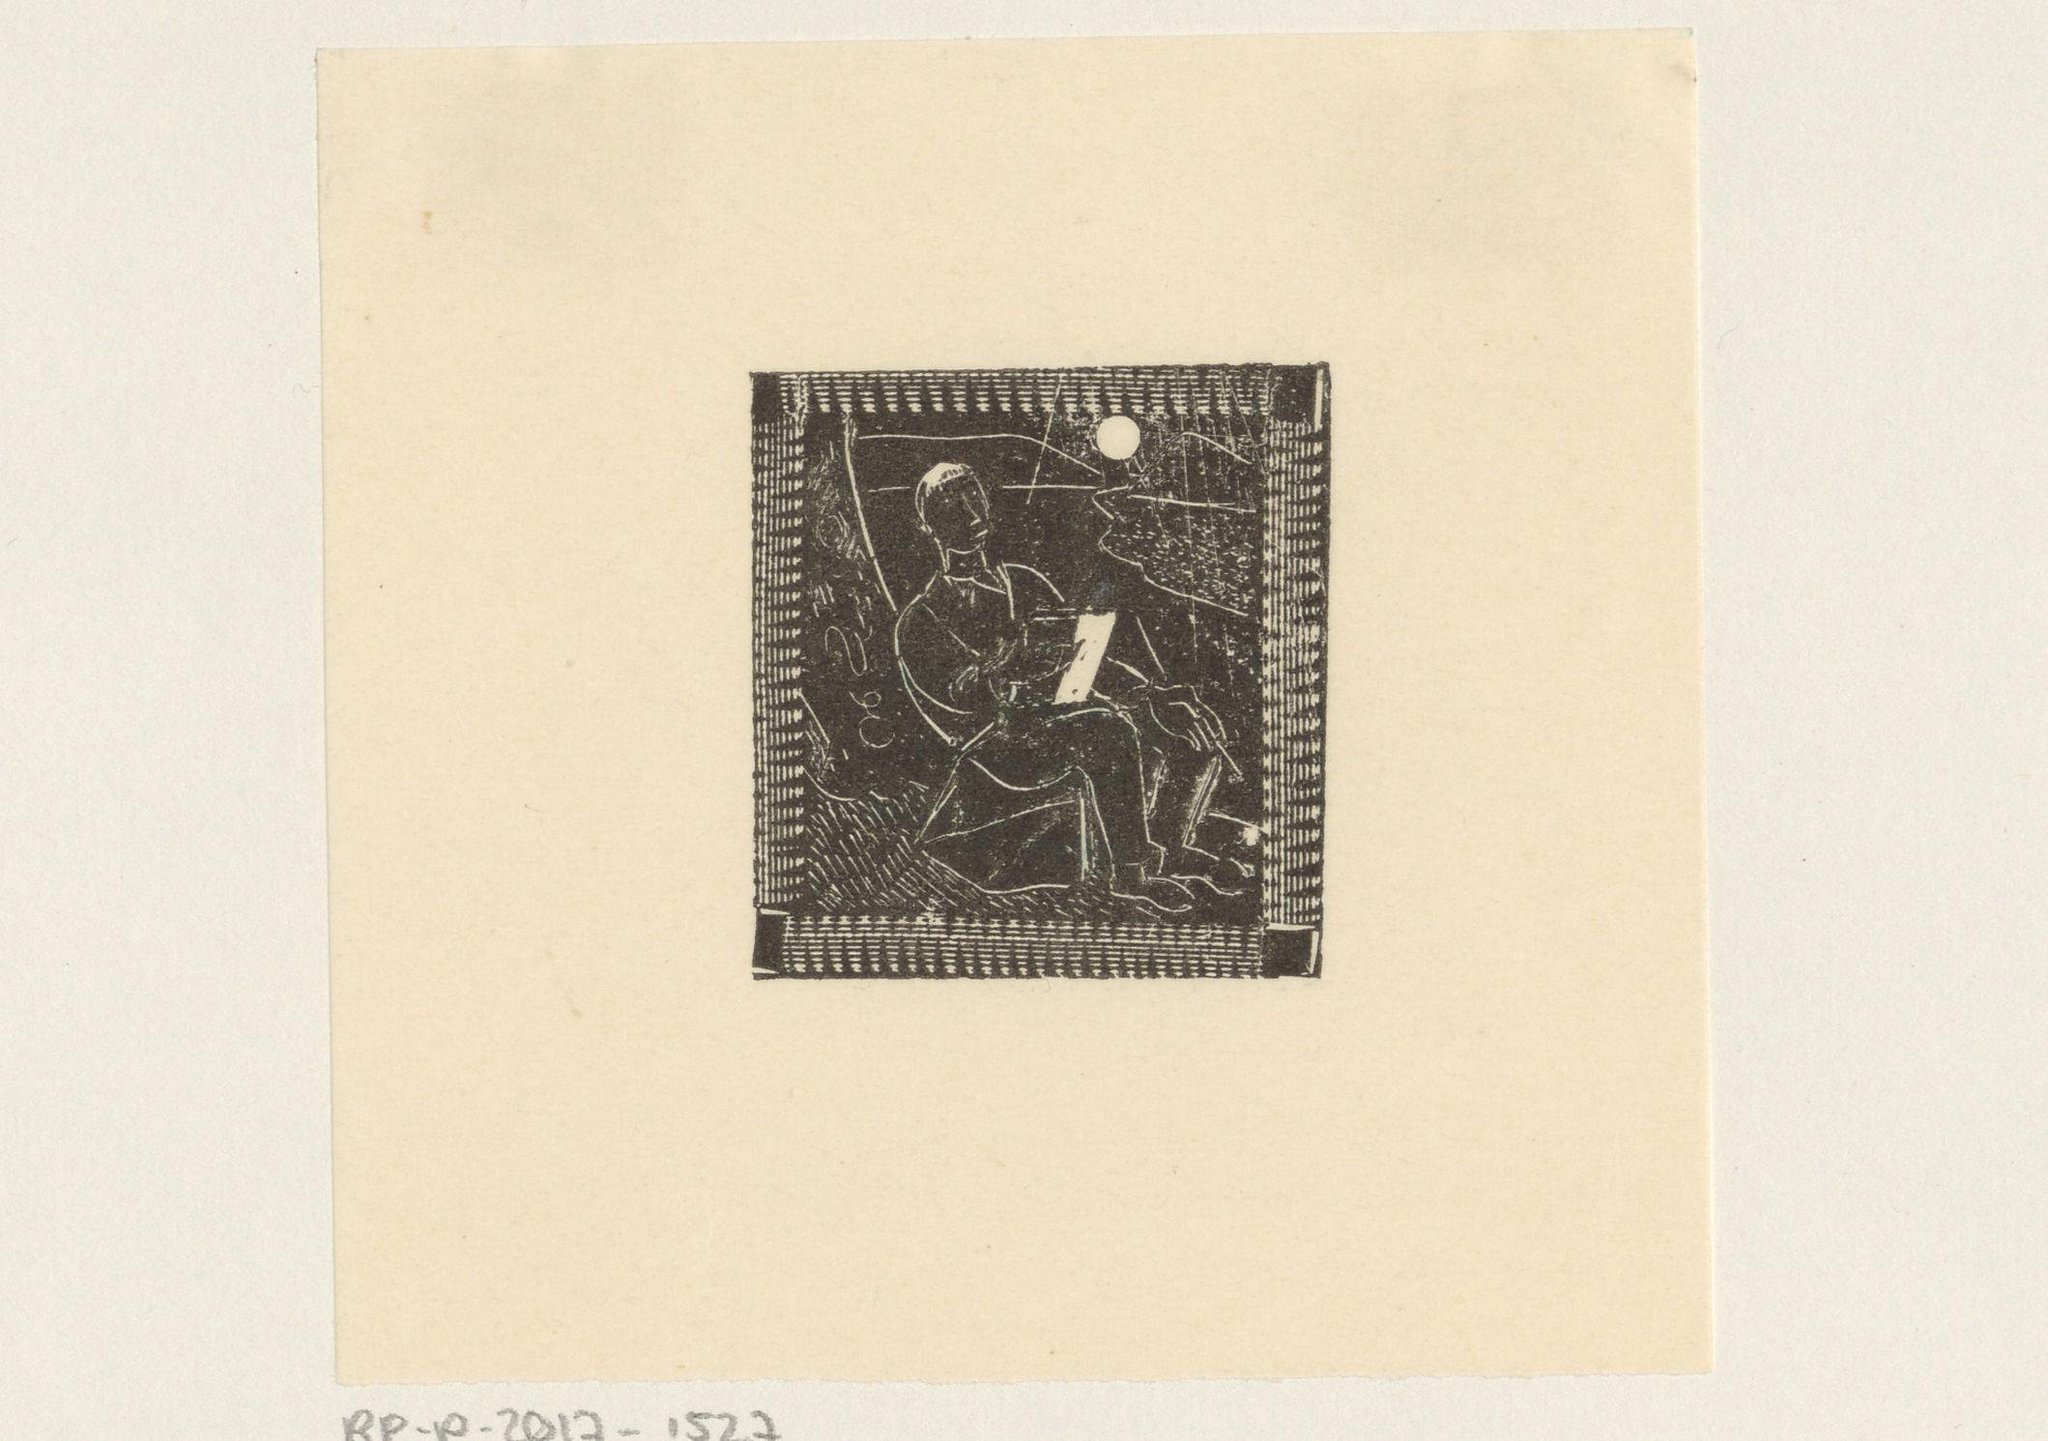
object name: bookplate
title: Eigendomsmerk van V.E.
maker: endre vadász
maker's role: painter, print maker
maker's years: 1901-1944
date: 1911-1944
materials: paper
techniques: engraving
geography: debrecen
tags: painter, endre vadász, sitting figure, reading, landscapes, sun as celestial body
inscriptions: workshop stamp: ‘Vadasz Endre / Debrecen / Arany János u. 19.’